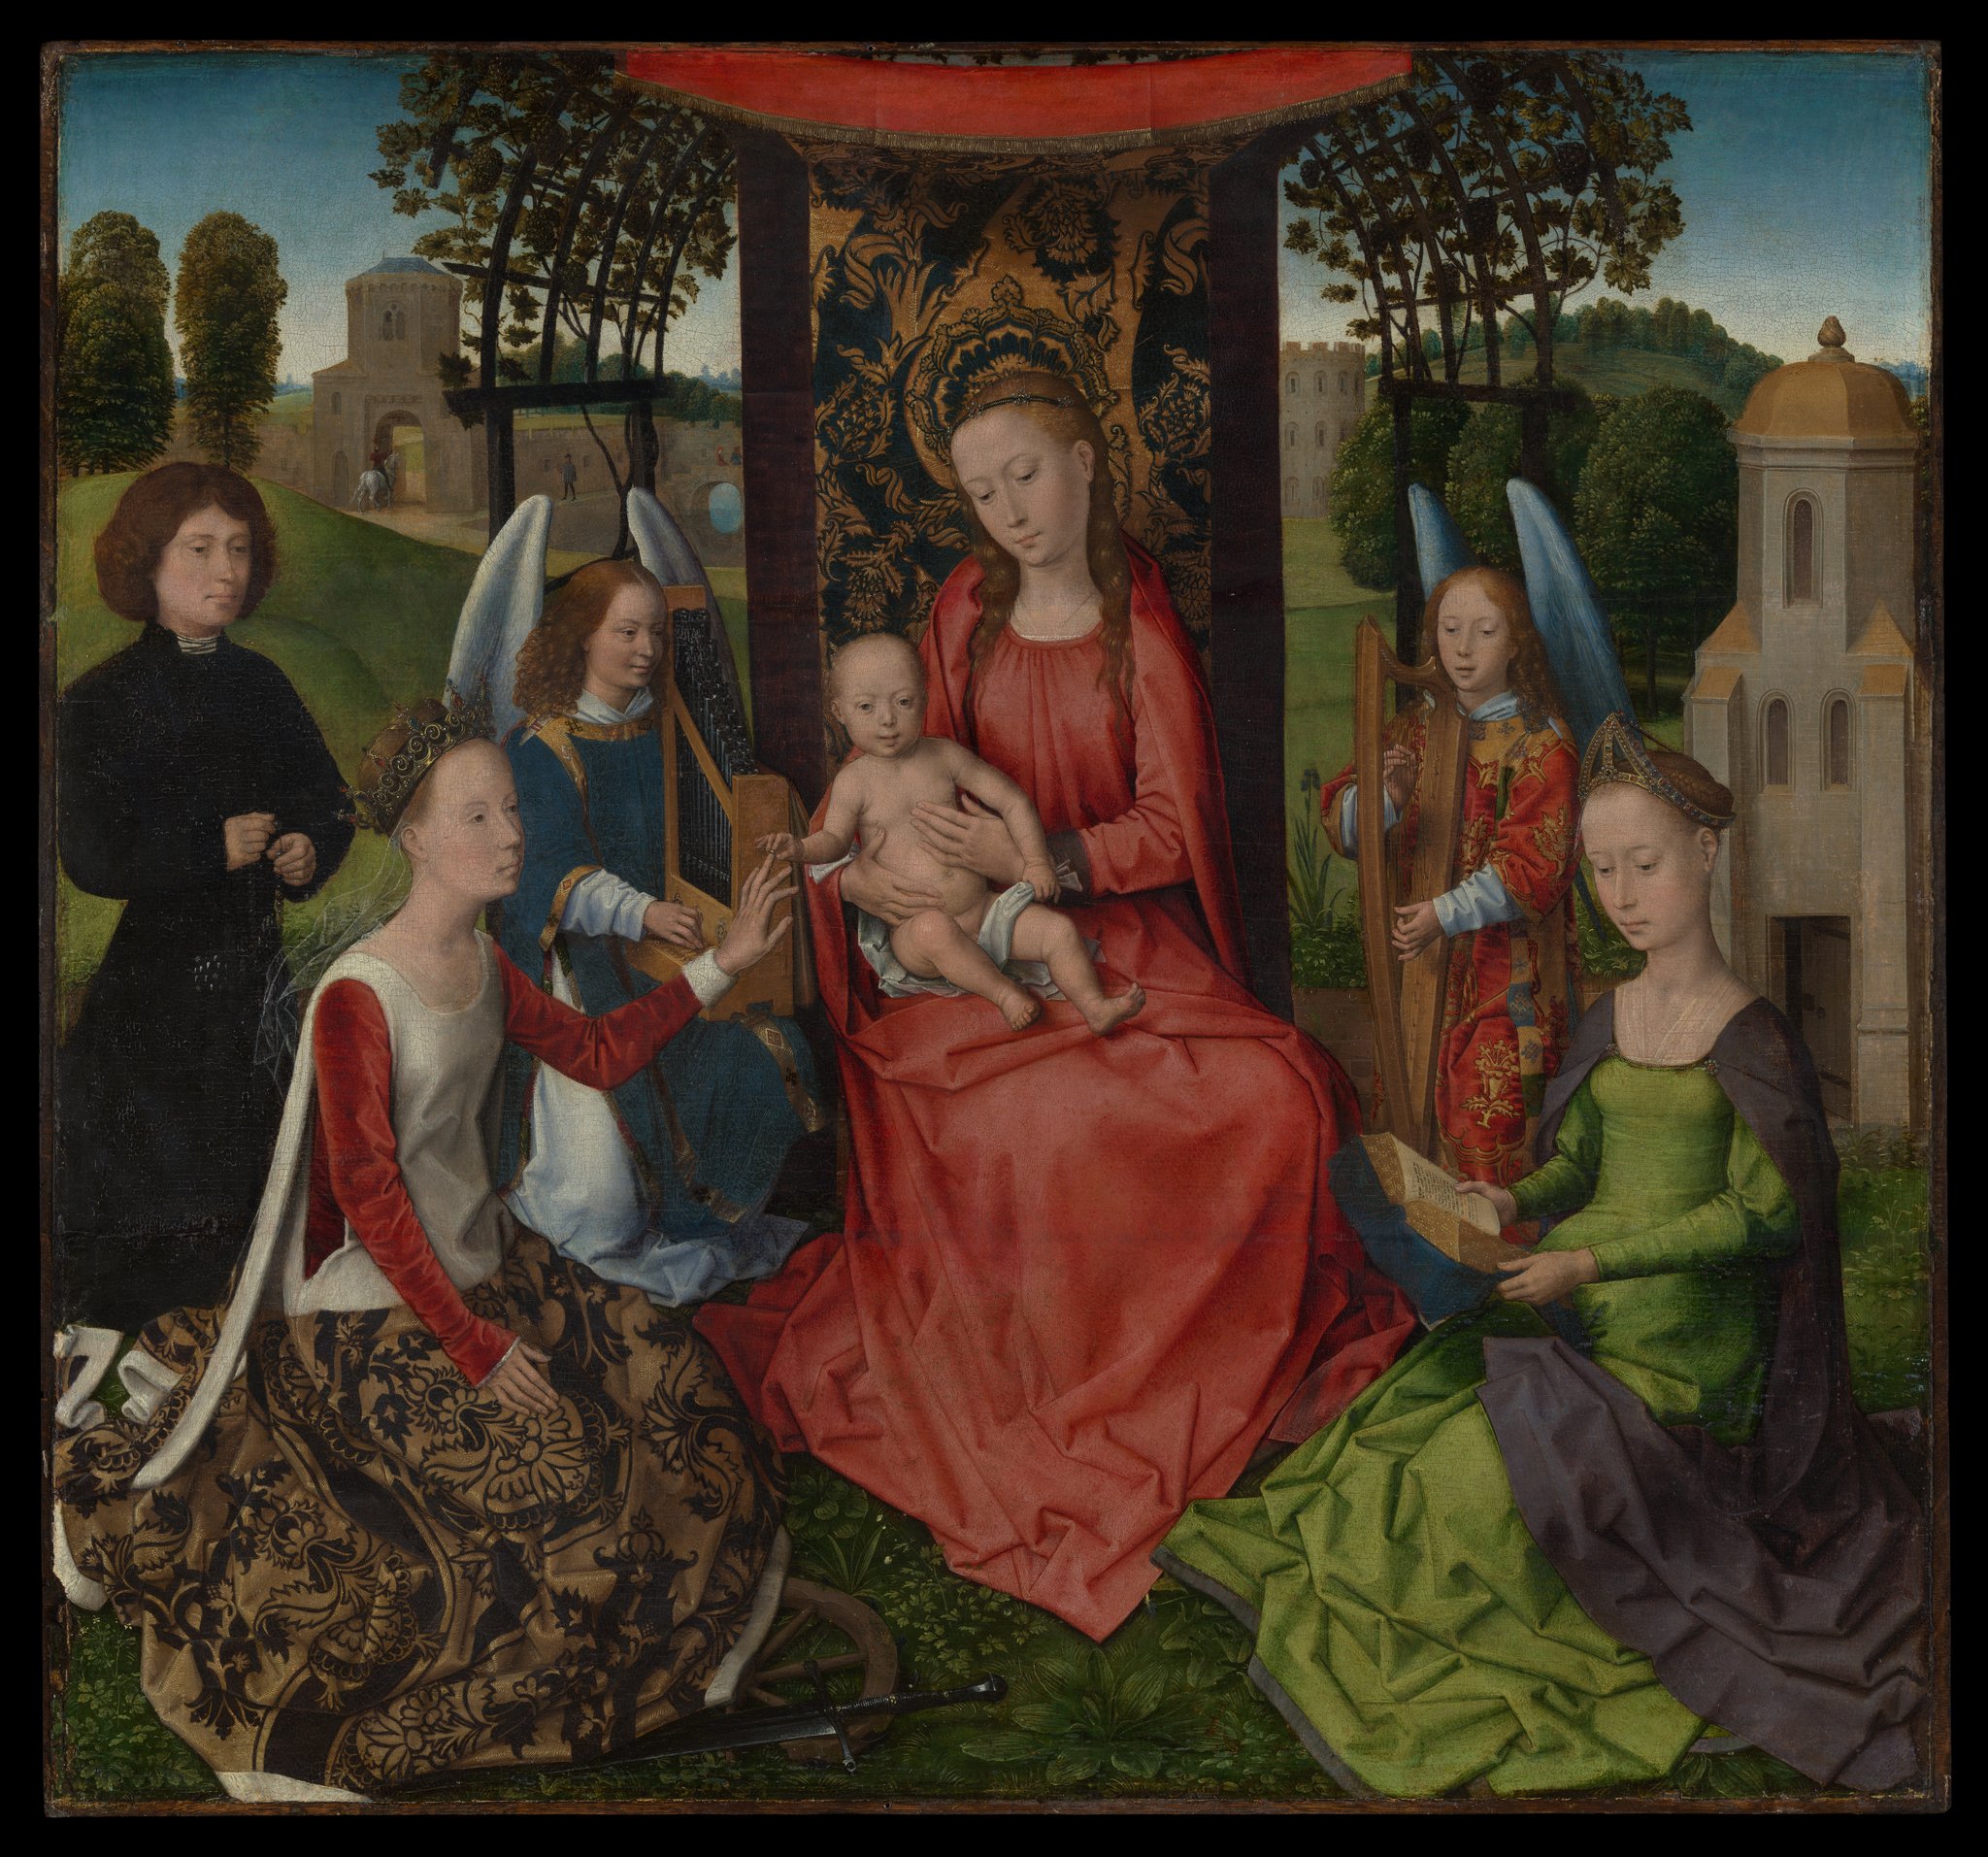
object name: painting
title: Virgin and Child with Saints Catherine of Alexandria and Barbara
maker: hans memling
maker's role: artist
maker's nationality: netherlandish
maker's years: 1465-1494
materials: oil, wood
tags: musical instruments,men,reading,angels,madonna and child,saint catherine,saint barbara